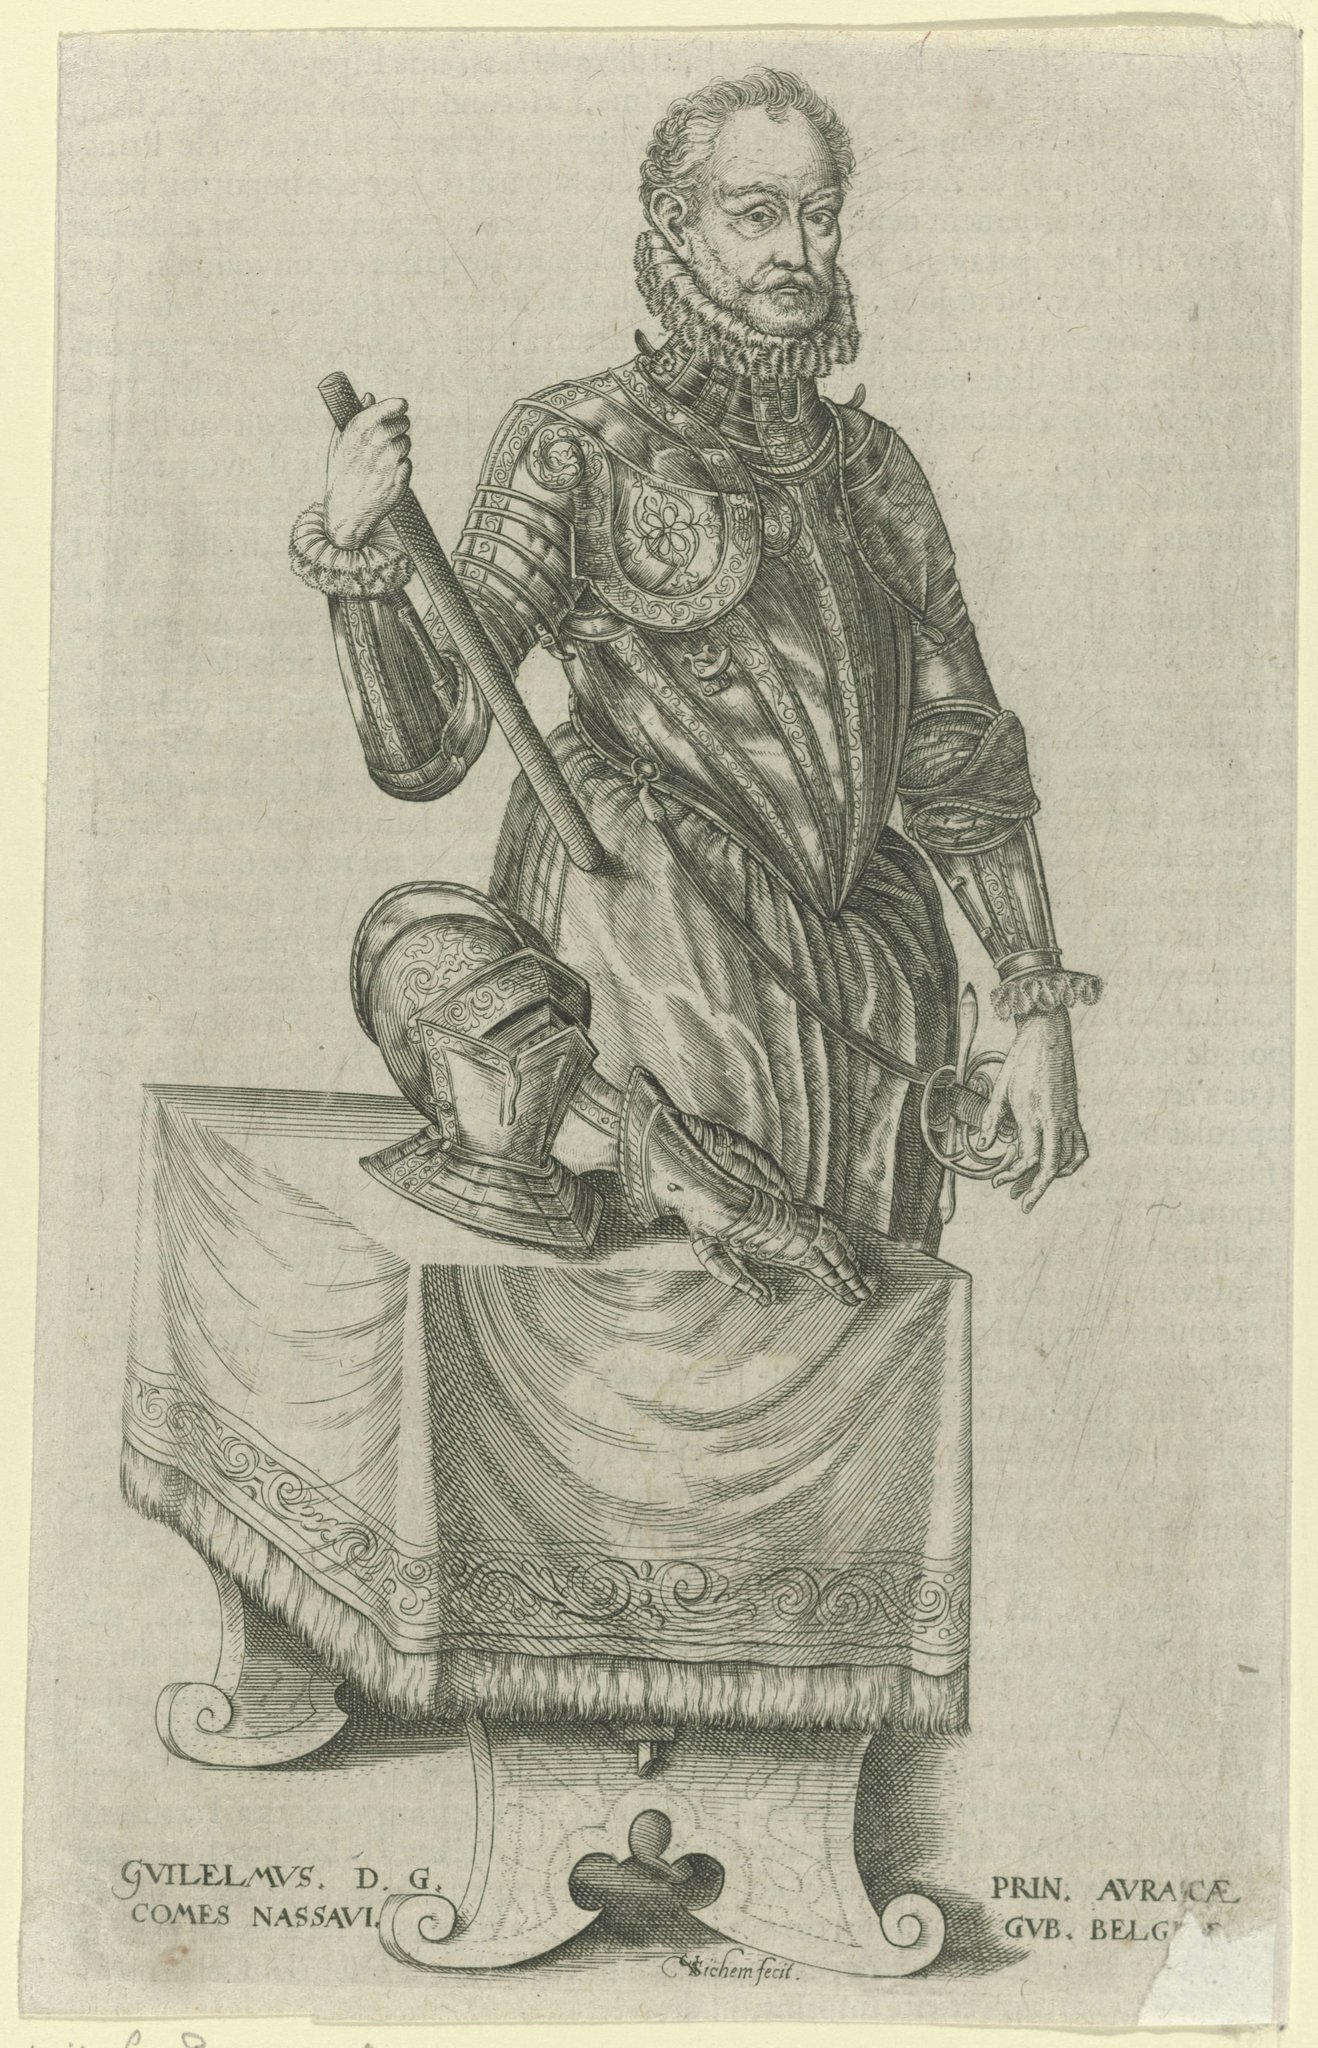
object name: book illustration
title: Portret van Willem I, prins van Oranje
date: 1601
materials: paper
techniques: engraving, etching, letterpress printing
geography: dordrecht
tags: delft, william i (prince of orange)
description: De hier vermelde titel verwijst naar de hoogst verkregen titel van de geportretteerde, niet per se naar de titel die de geportretteerde op deze voorstelling draagt. Prent uit: Le Petit, Jean François. La grande chroniqve ancienne et moderne, de Hollande, Zelande, VVestfrise, Vtrecht, Frise, Overyssel & Groeningen. Dordrecht: Jacob Canin, 1601.